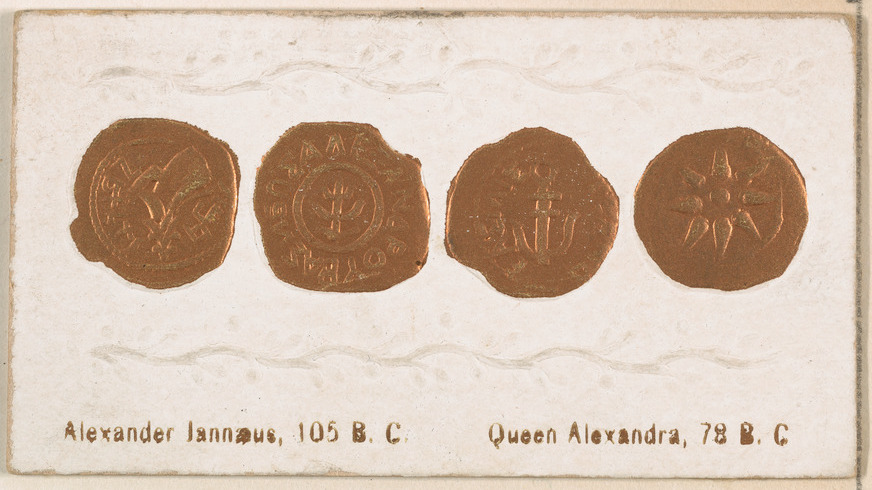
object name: print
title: Alexander Jannaeus, 105 B.C. / Queen Alexandra, 78 B.C., from the Ancient Coins series (N180) issued by Wm. S. Kimball & Co.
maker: william s. kimball & company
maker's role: publisher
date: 1888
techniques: color lithograph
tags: coins